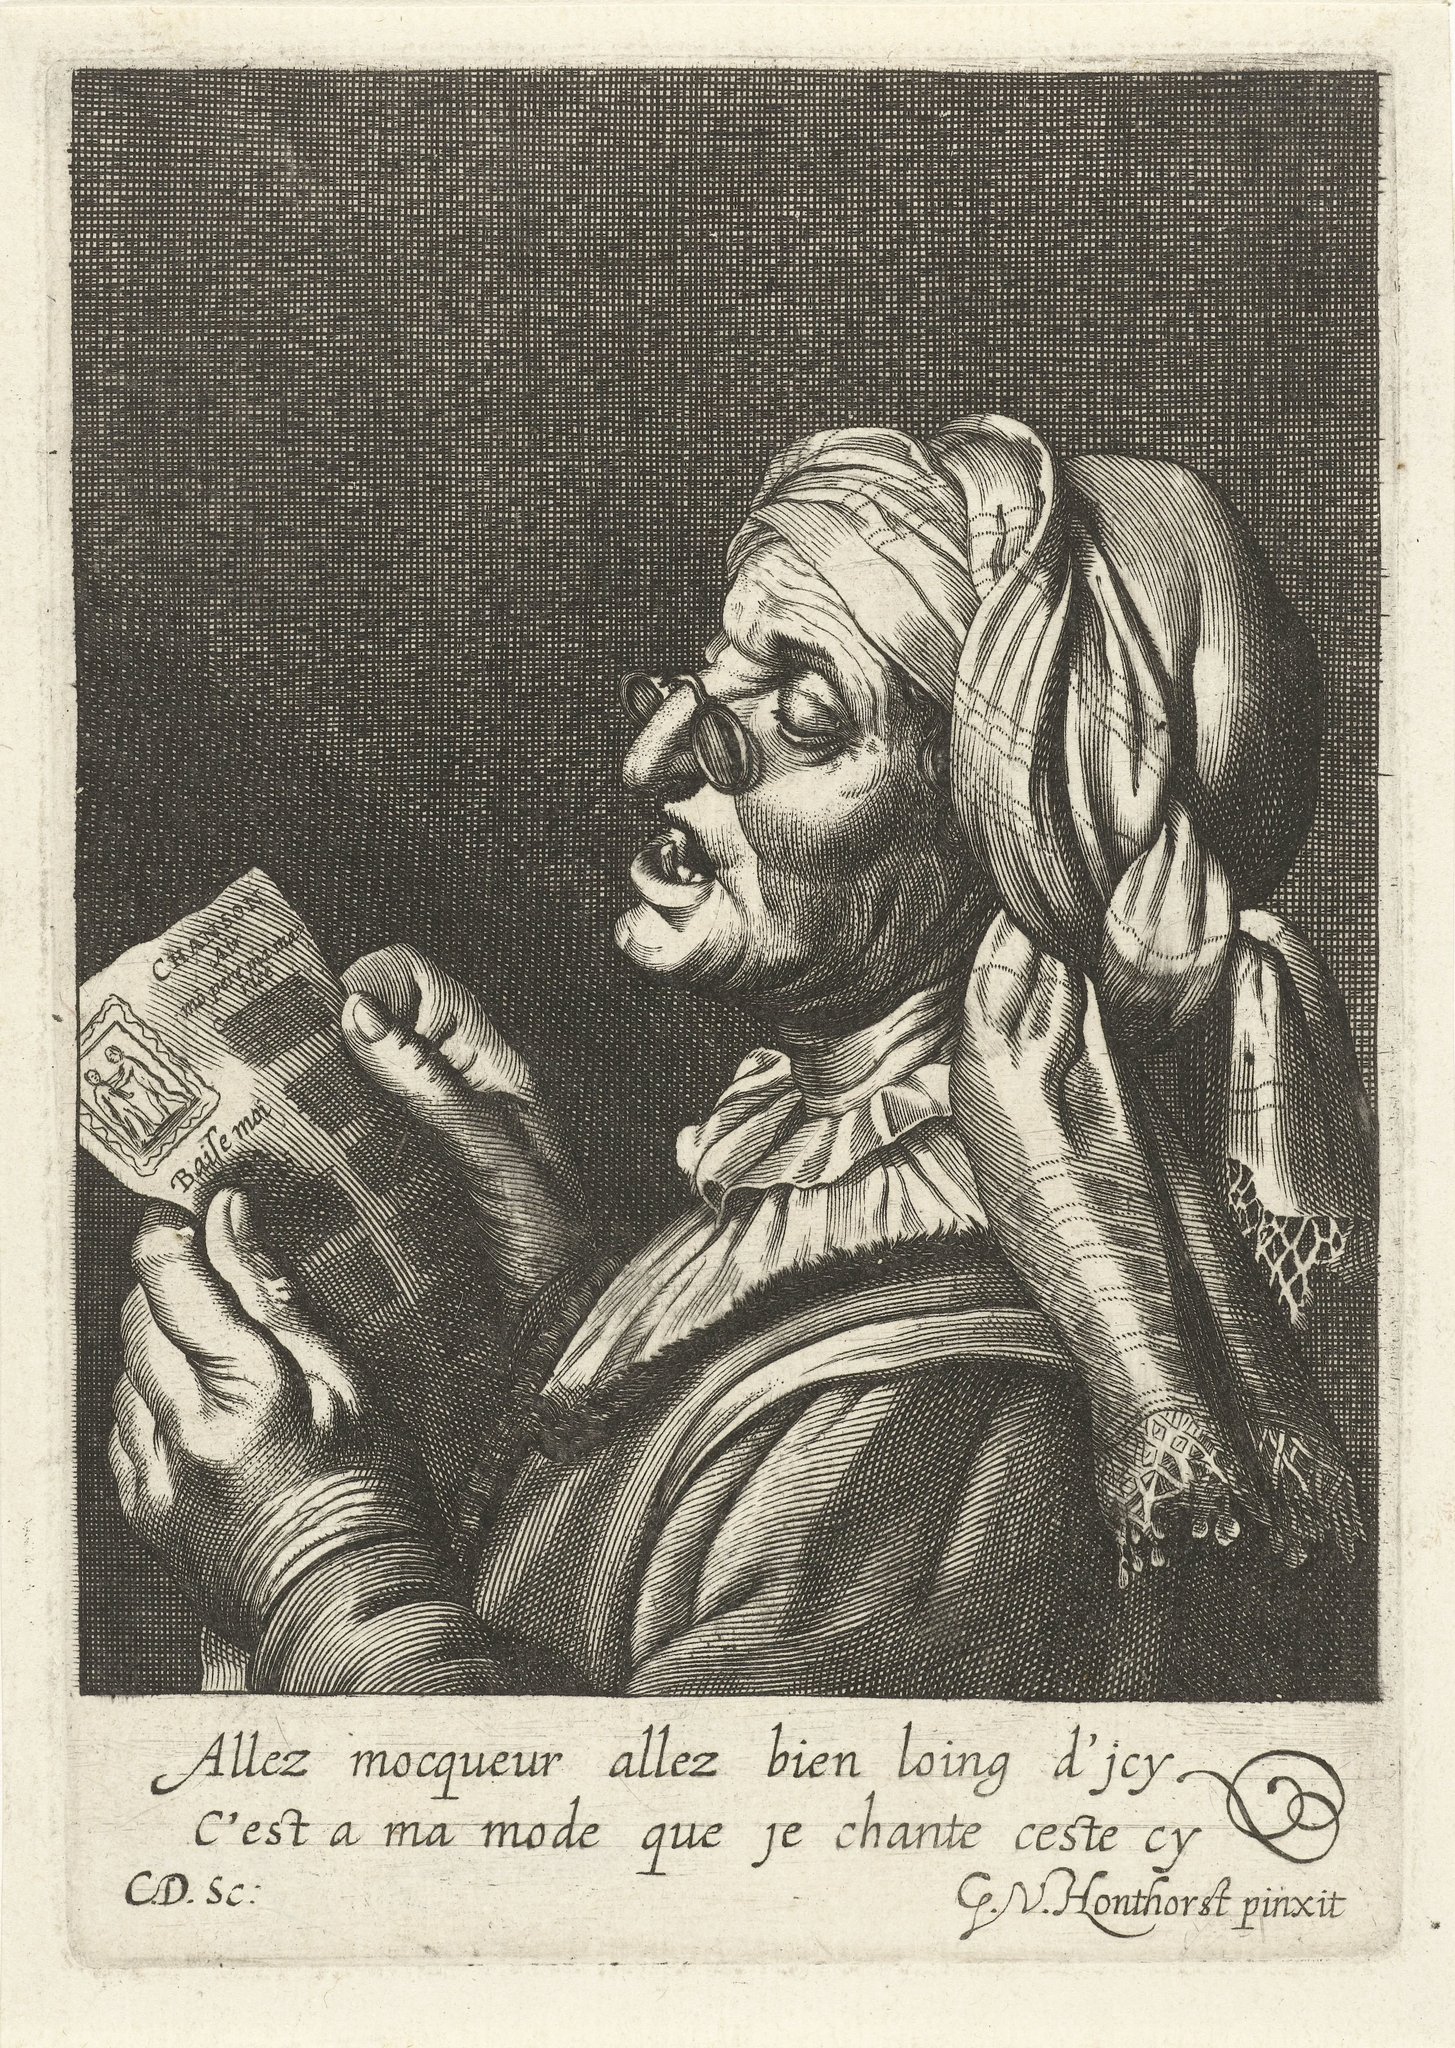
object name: print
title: Oude vrouw zingt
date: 1612-1665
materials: paper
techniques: engraving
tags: old woman, vocal music, singing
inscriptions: collector's mark: Lugt 2228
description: Oude vrouw met bril op haar kromme neus zingt een lied dat zij leest van een blad papier voor zich. In de ondermarge Frans vers.